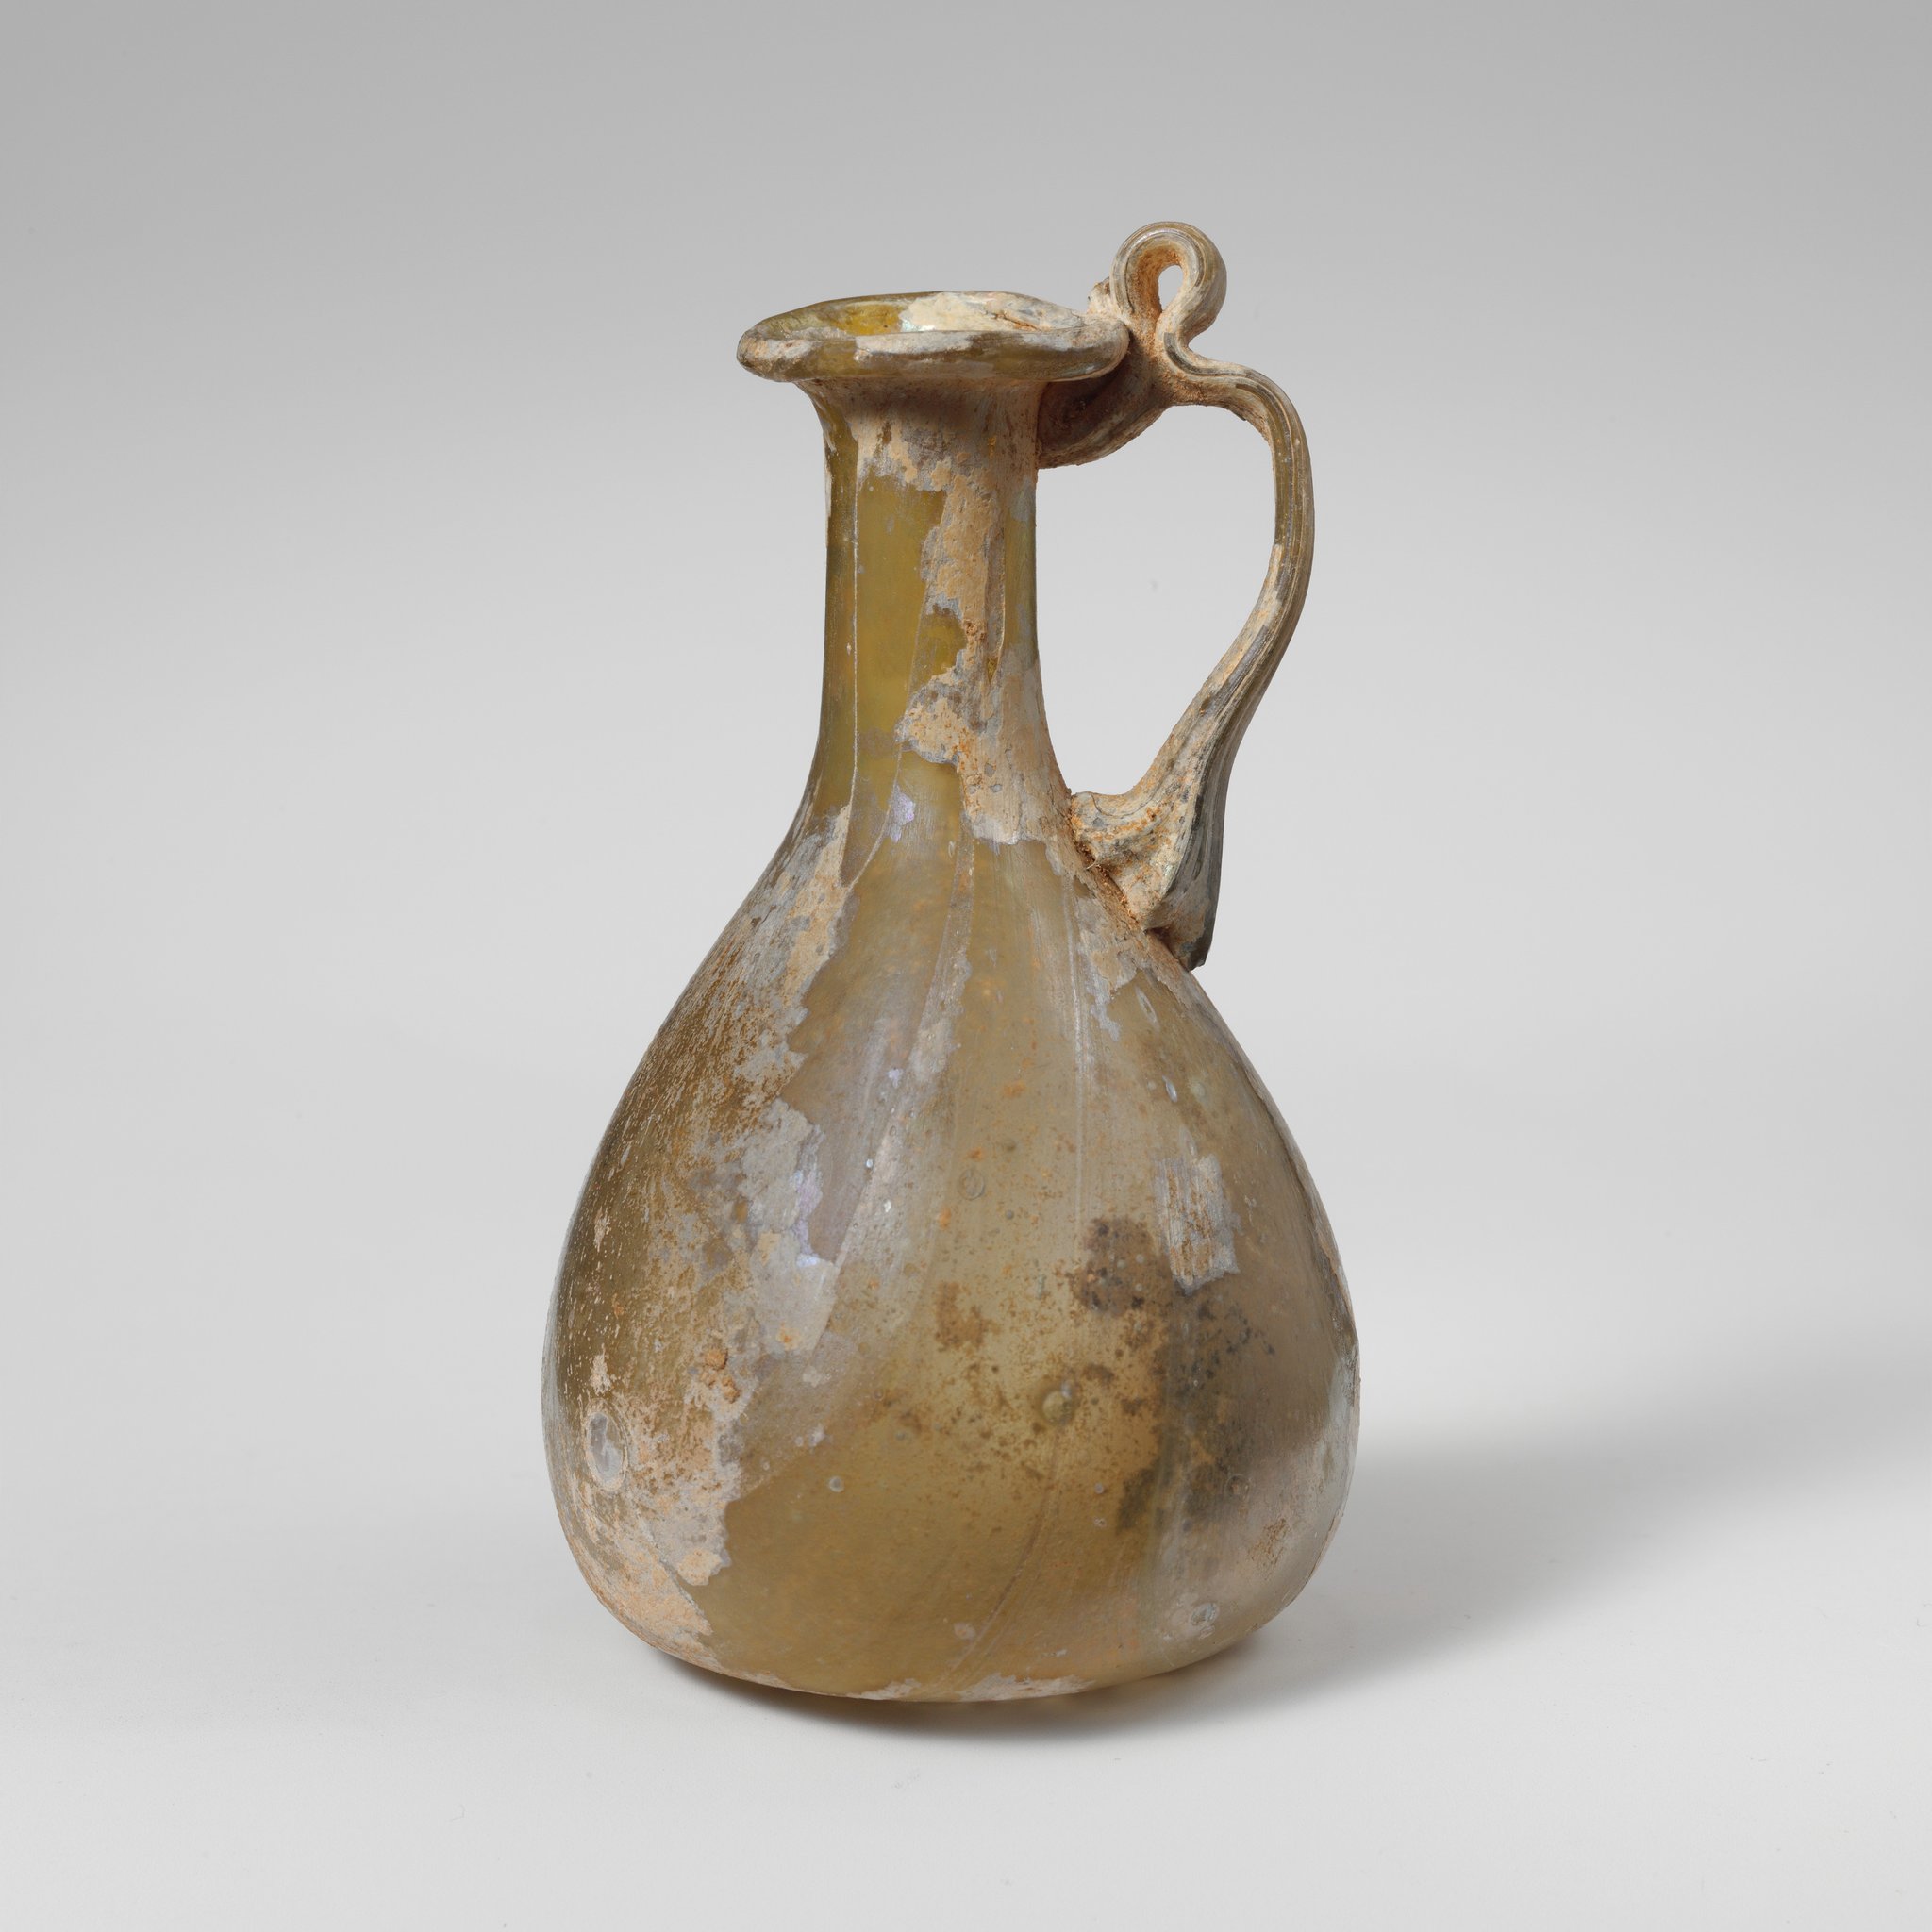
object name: jug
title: Glass jug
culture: roman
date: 101-300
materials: glass